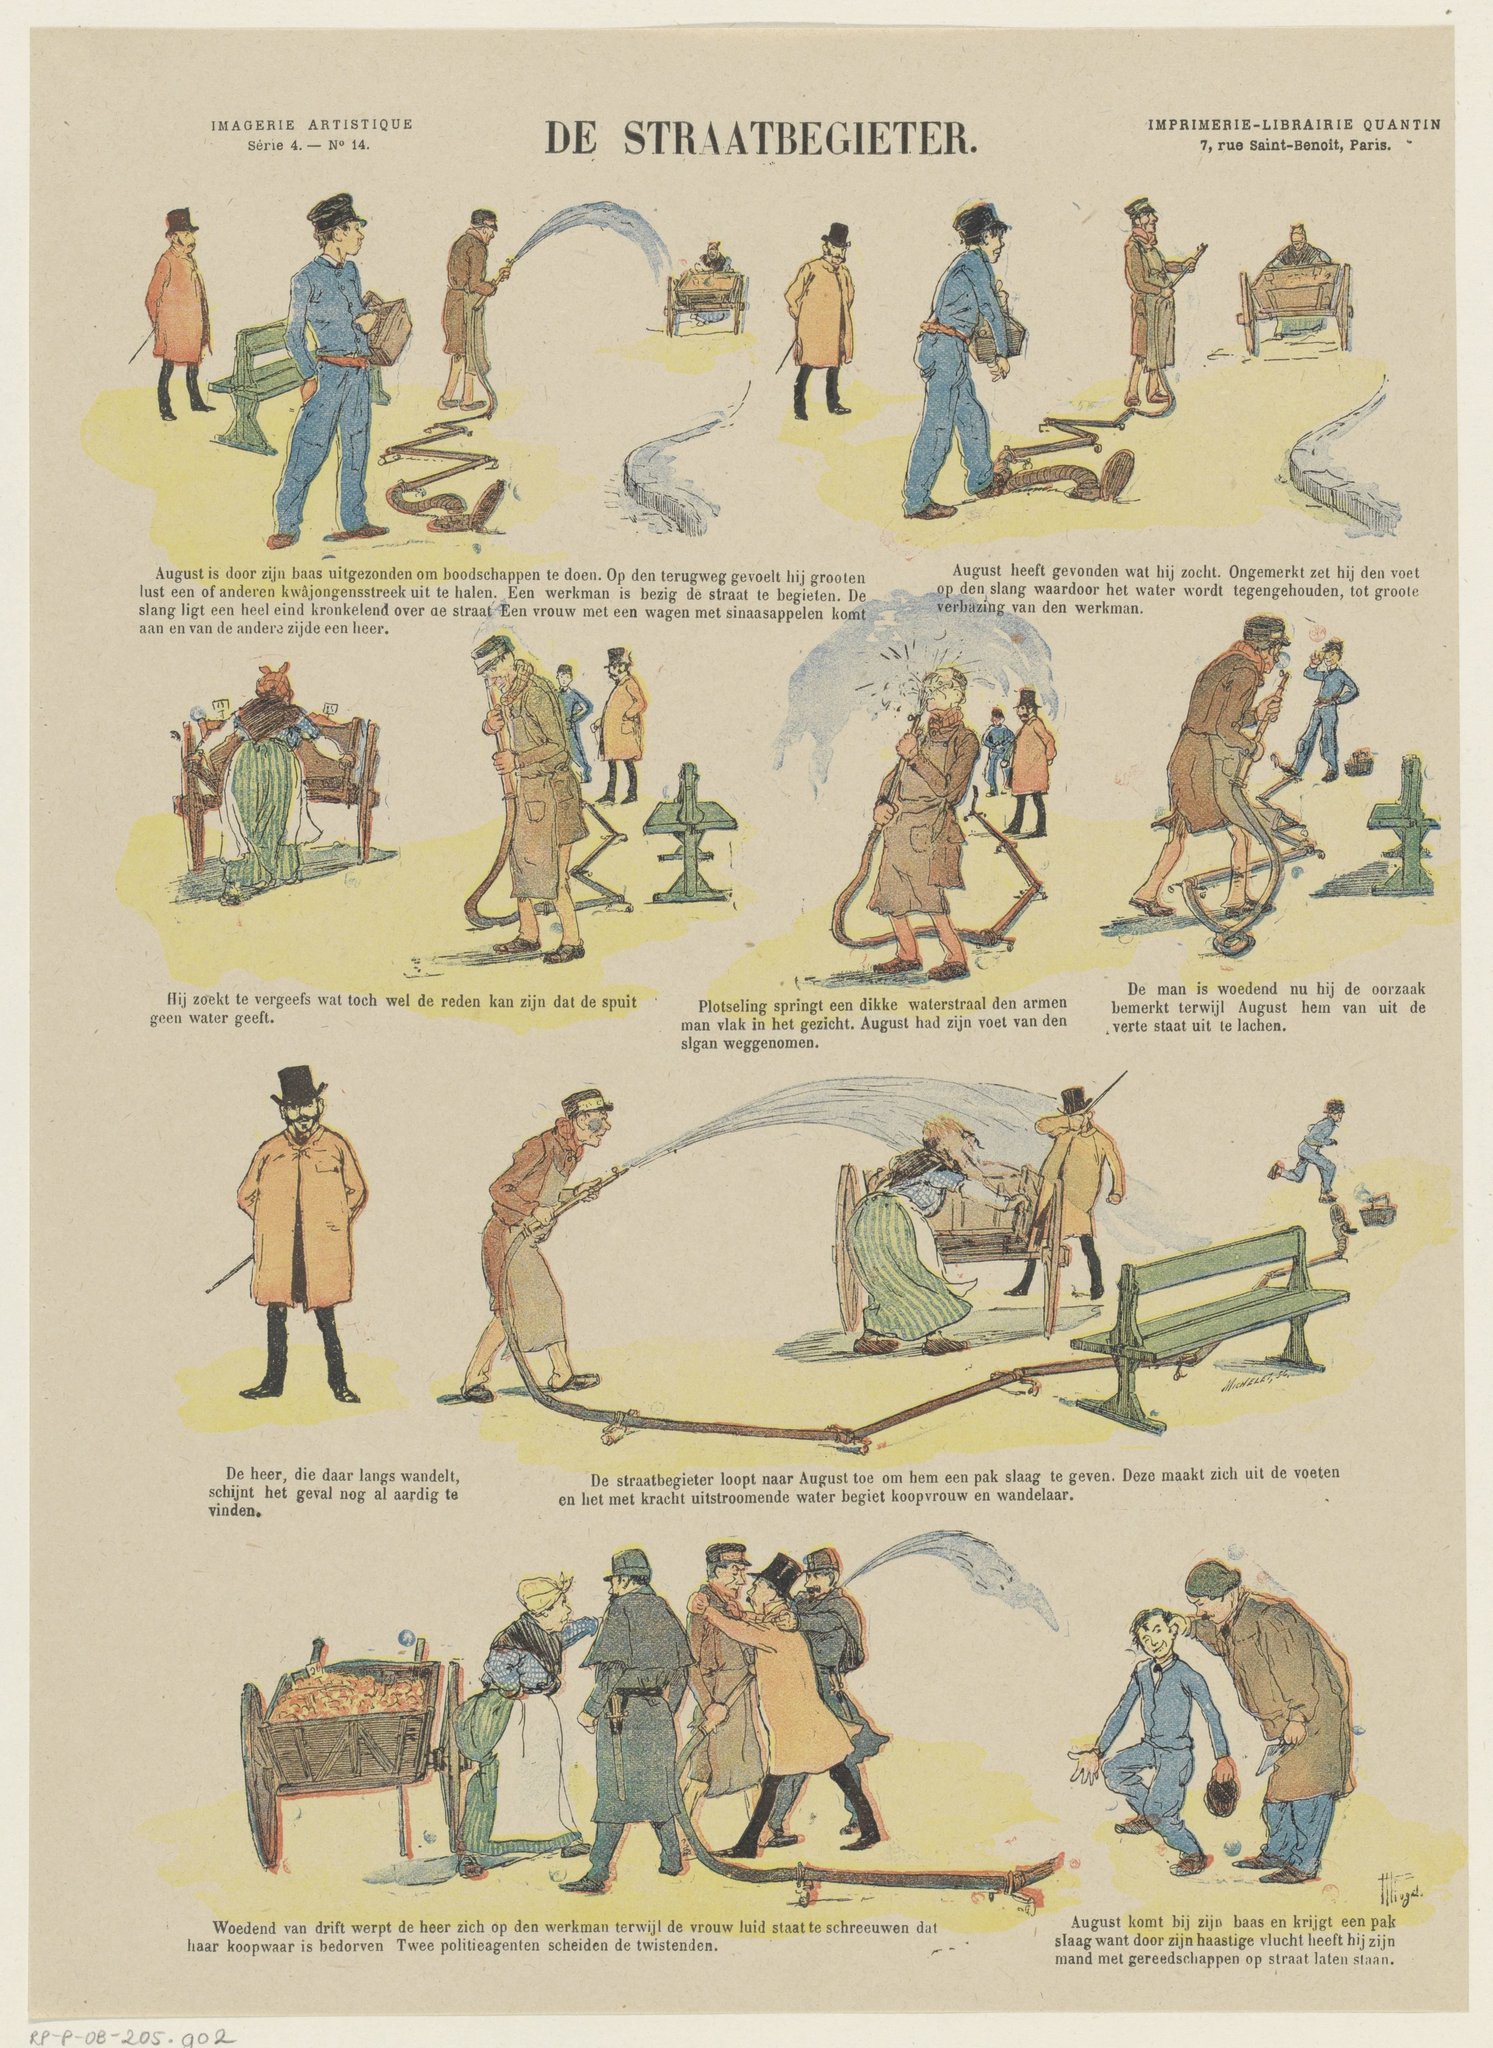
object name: print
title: Imagerie Artistique / Série 4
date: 1876-1890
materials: paper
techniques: lithograph, letterpress printing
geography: paris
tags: mischief-making play, tales and fairy tales, comedy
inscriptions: collector's mark: Lugt 2760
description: Blad met 4 rijen met voorstellingen van een kwajongen die een streek uithaalt met een straatbegieter. Onder elke voorstelling een onderschrift. Genummerd linksboven: Série 4. - No. 14.